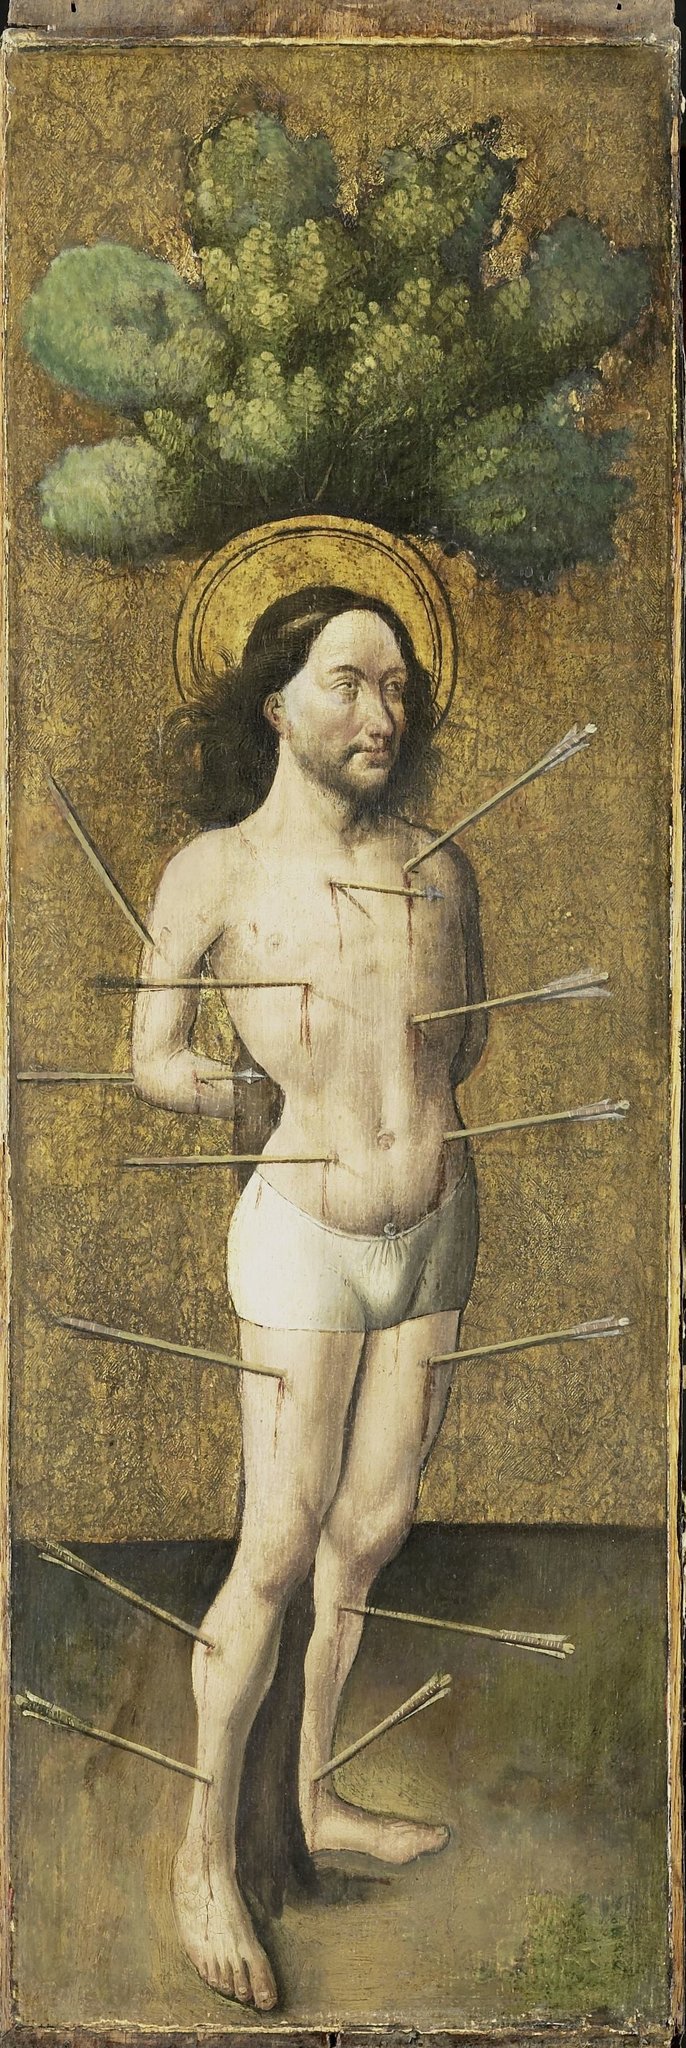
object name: zijpaneel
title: Saint Sebastian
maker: meester e.s.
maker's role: print maker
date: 1460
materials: oil, panel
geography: upper rhine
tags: st. sebastian, tied to a tree or a pillar, is pierced by arrows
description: De heilige Sebastiaan, ten voeten uit, gebonden aan een boom, doorbood met pijlen. Linker zijpaneel van een altaarstuk. Pendant van SK-A-3310.